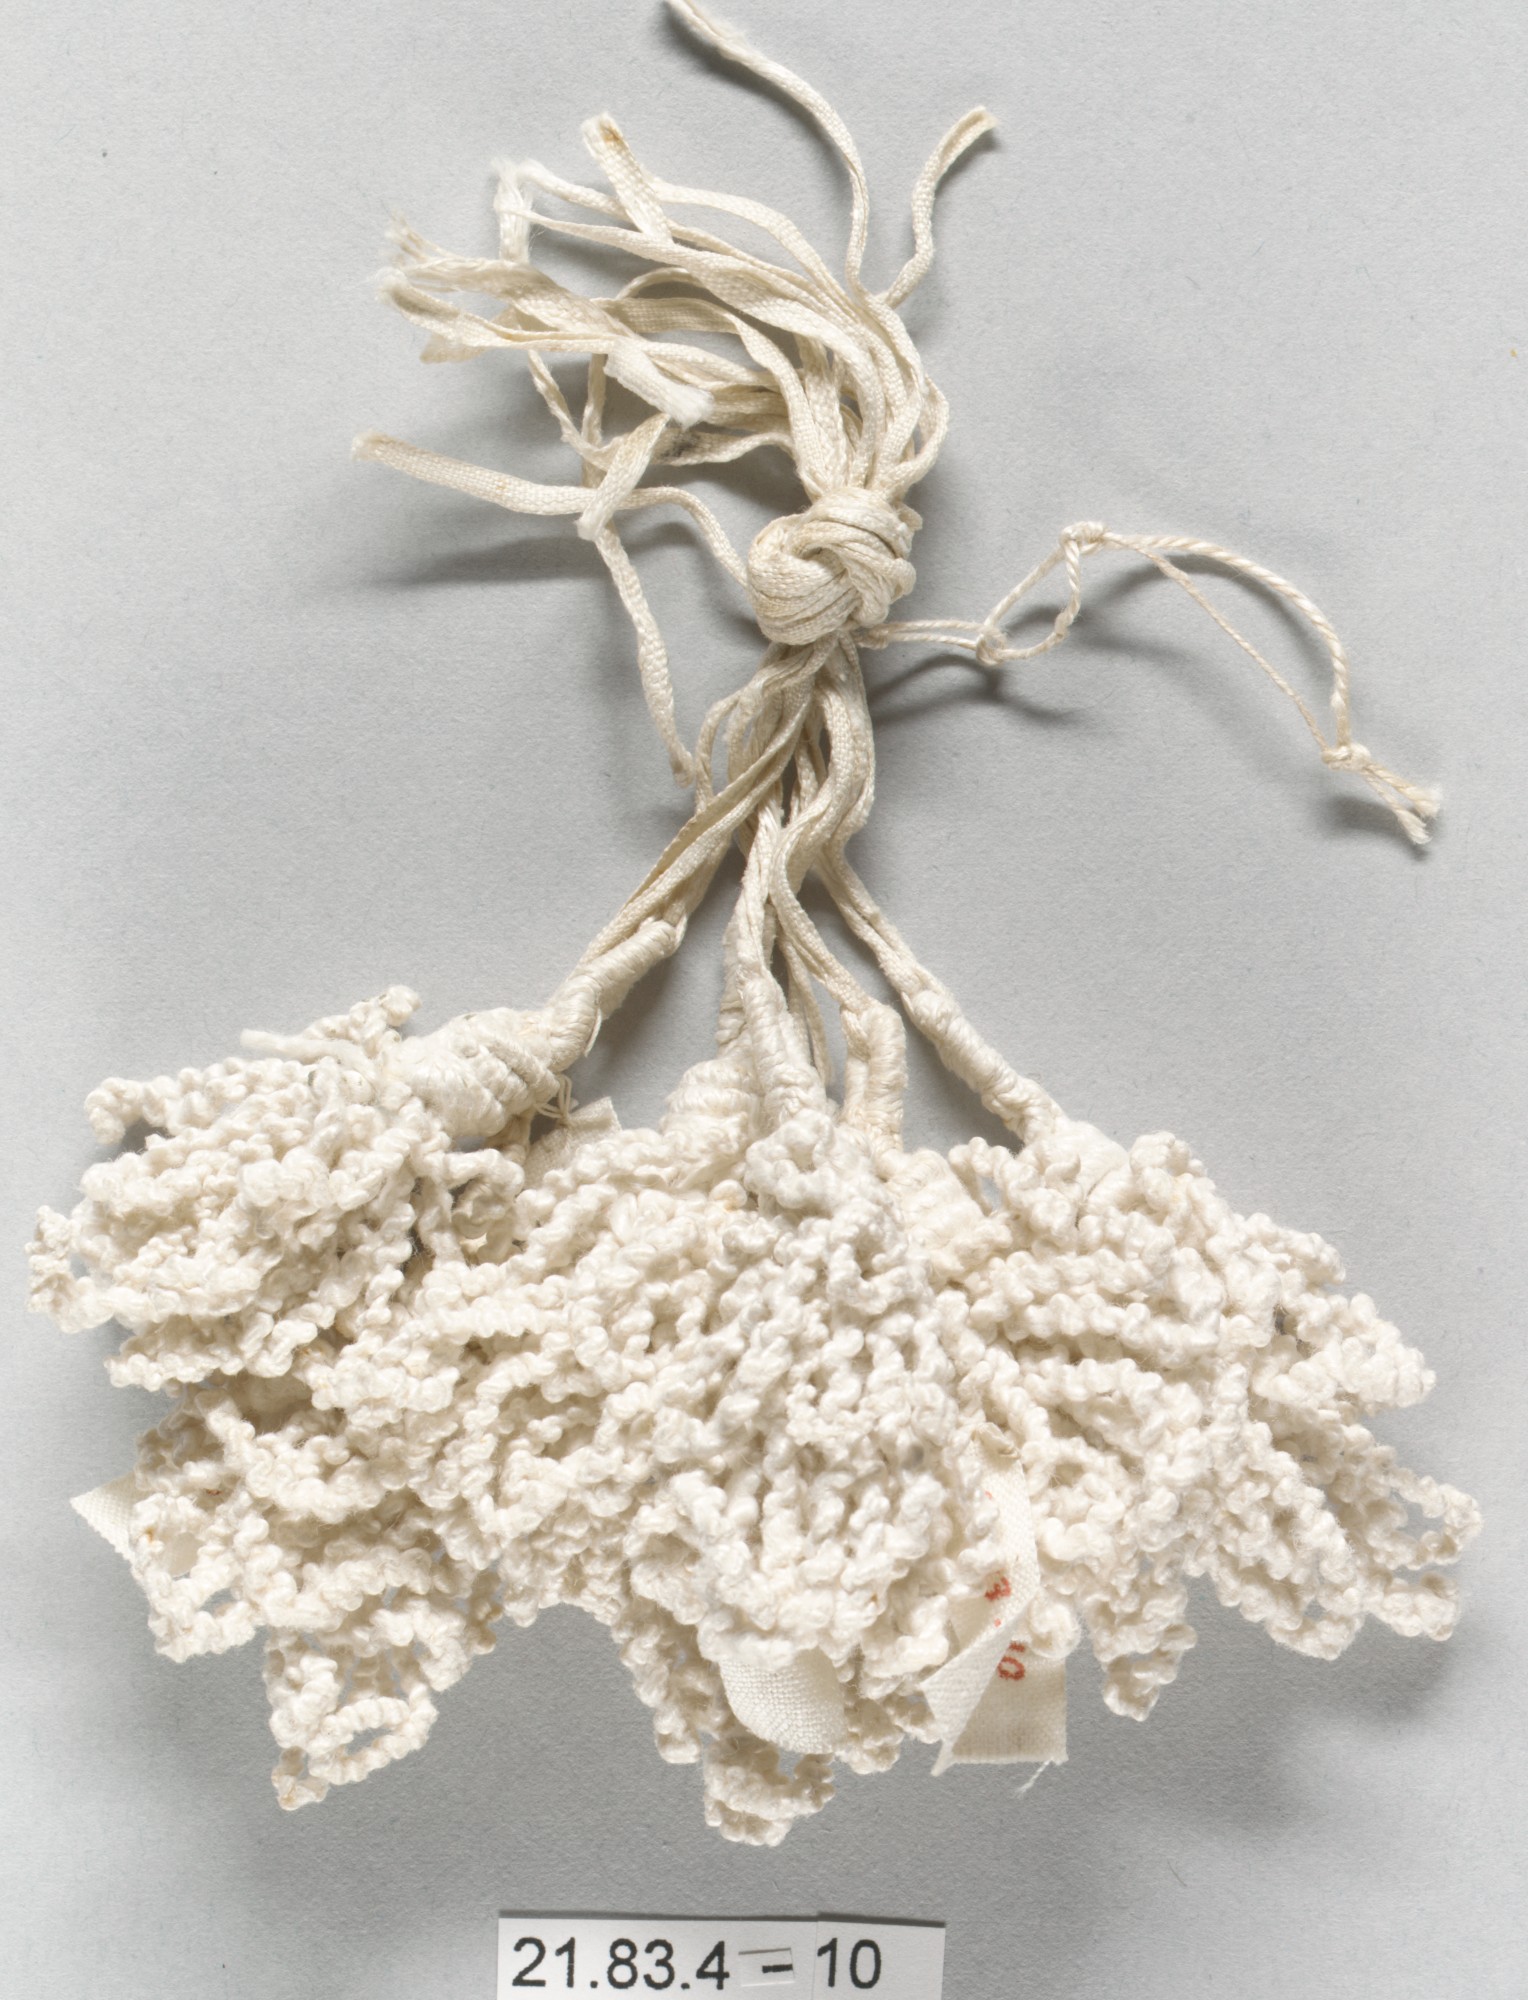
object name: tassel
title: Group of tassels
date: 1601-1700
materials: linen